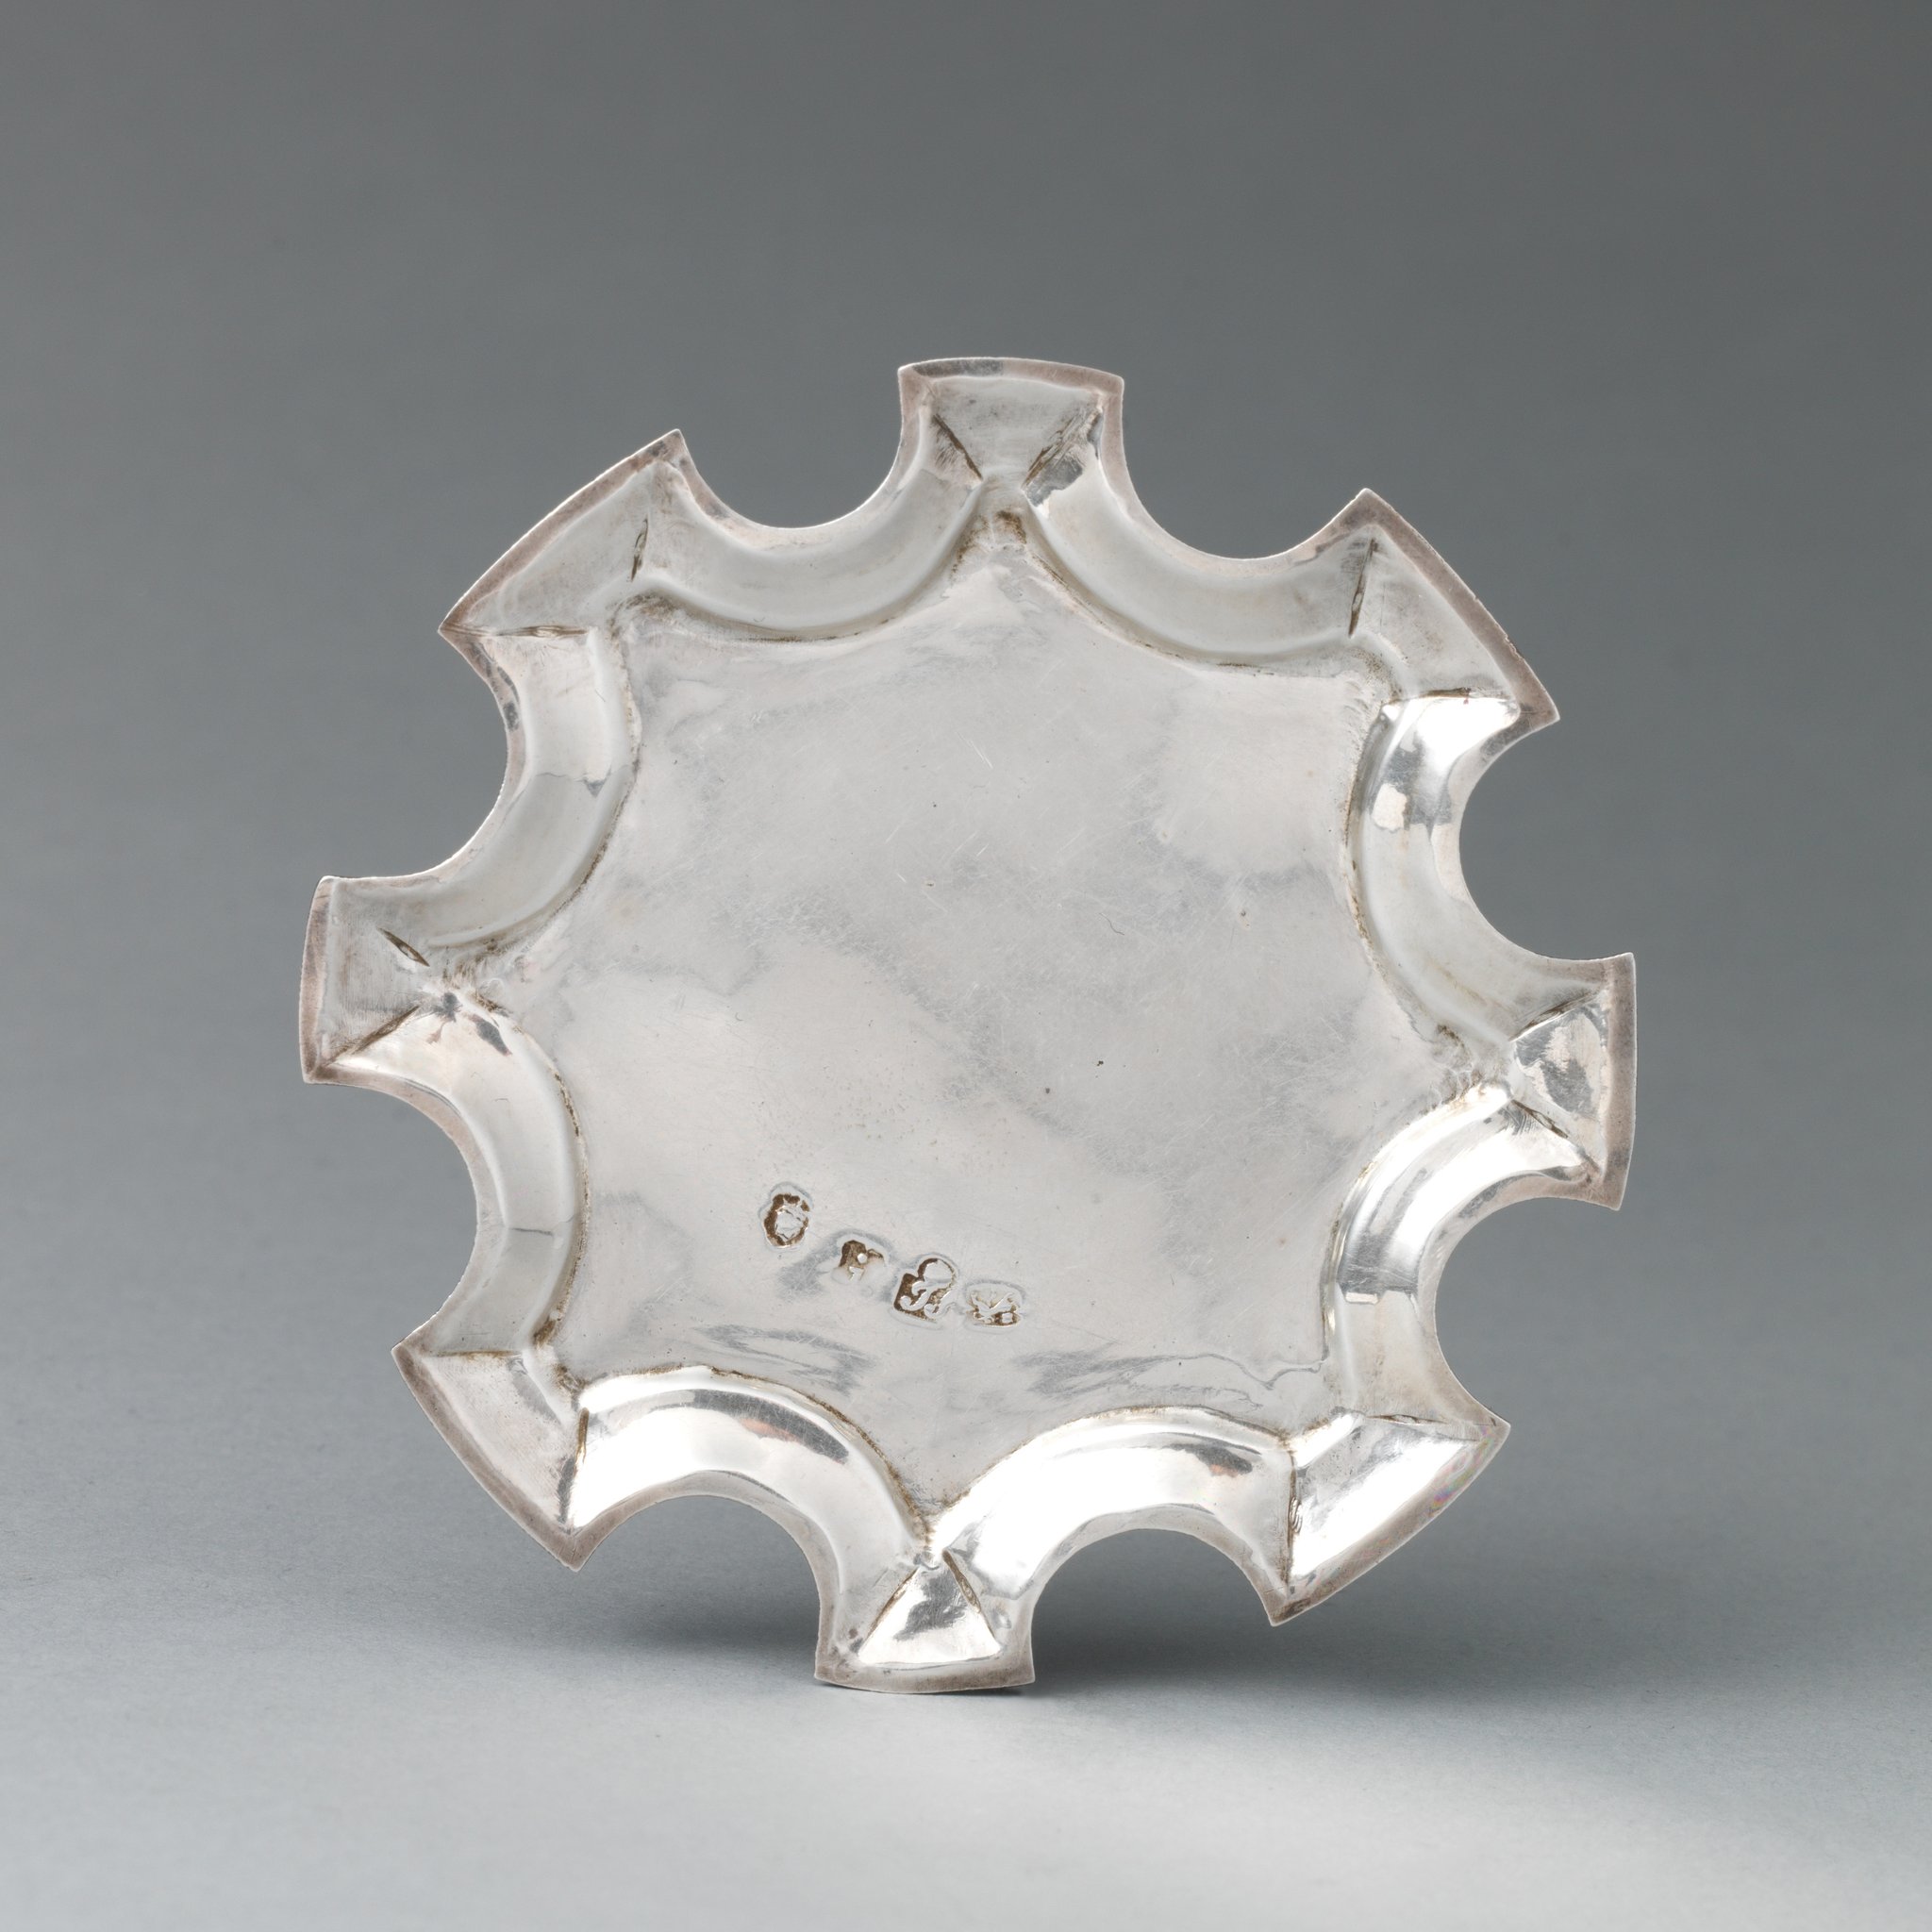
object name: waiter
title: Miniature waiter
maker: john le sage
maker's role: maker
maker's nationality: british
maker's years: 1718-1743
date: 1744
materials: silver